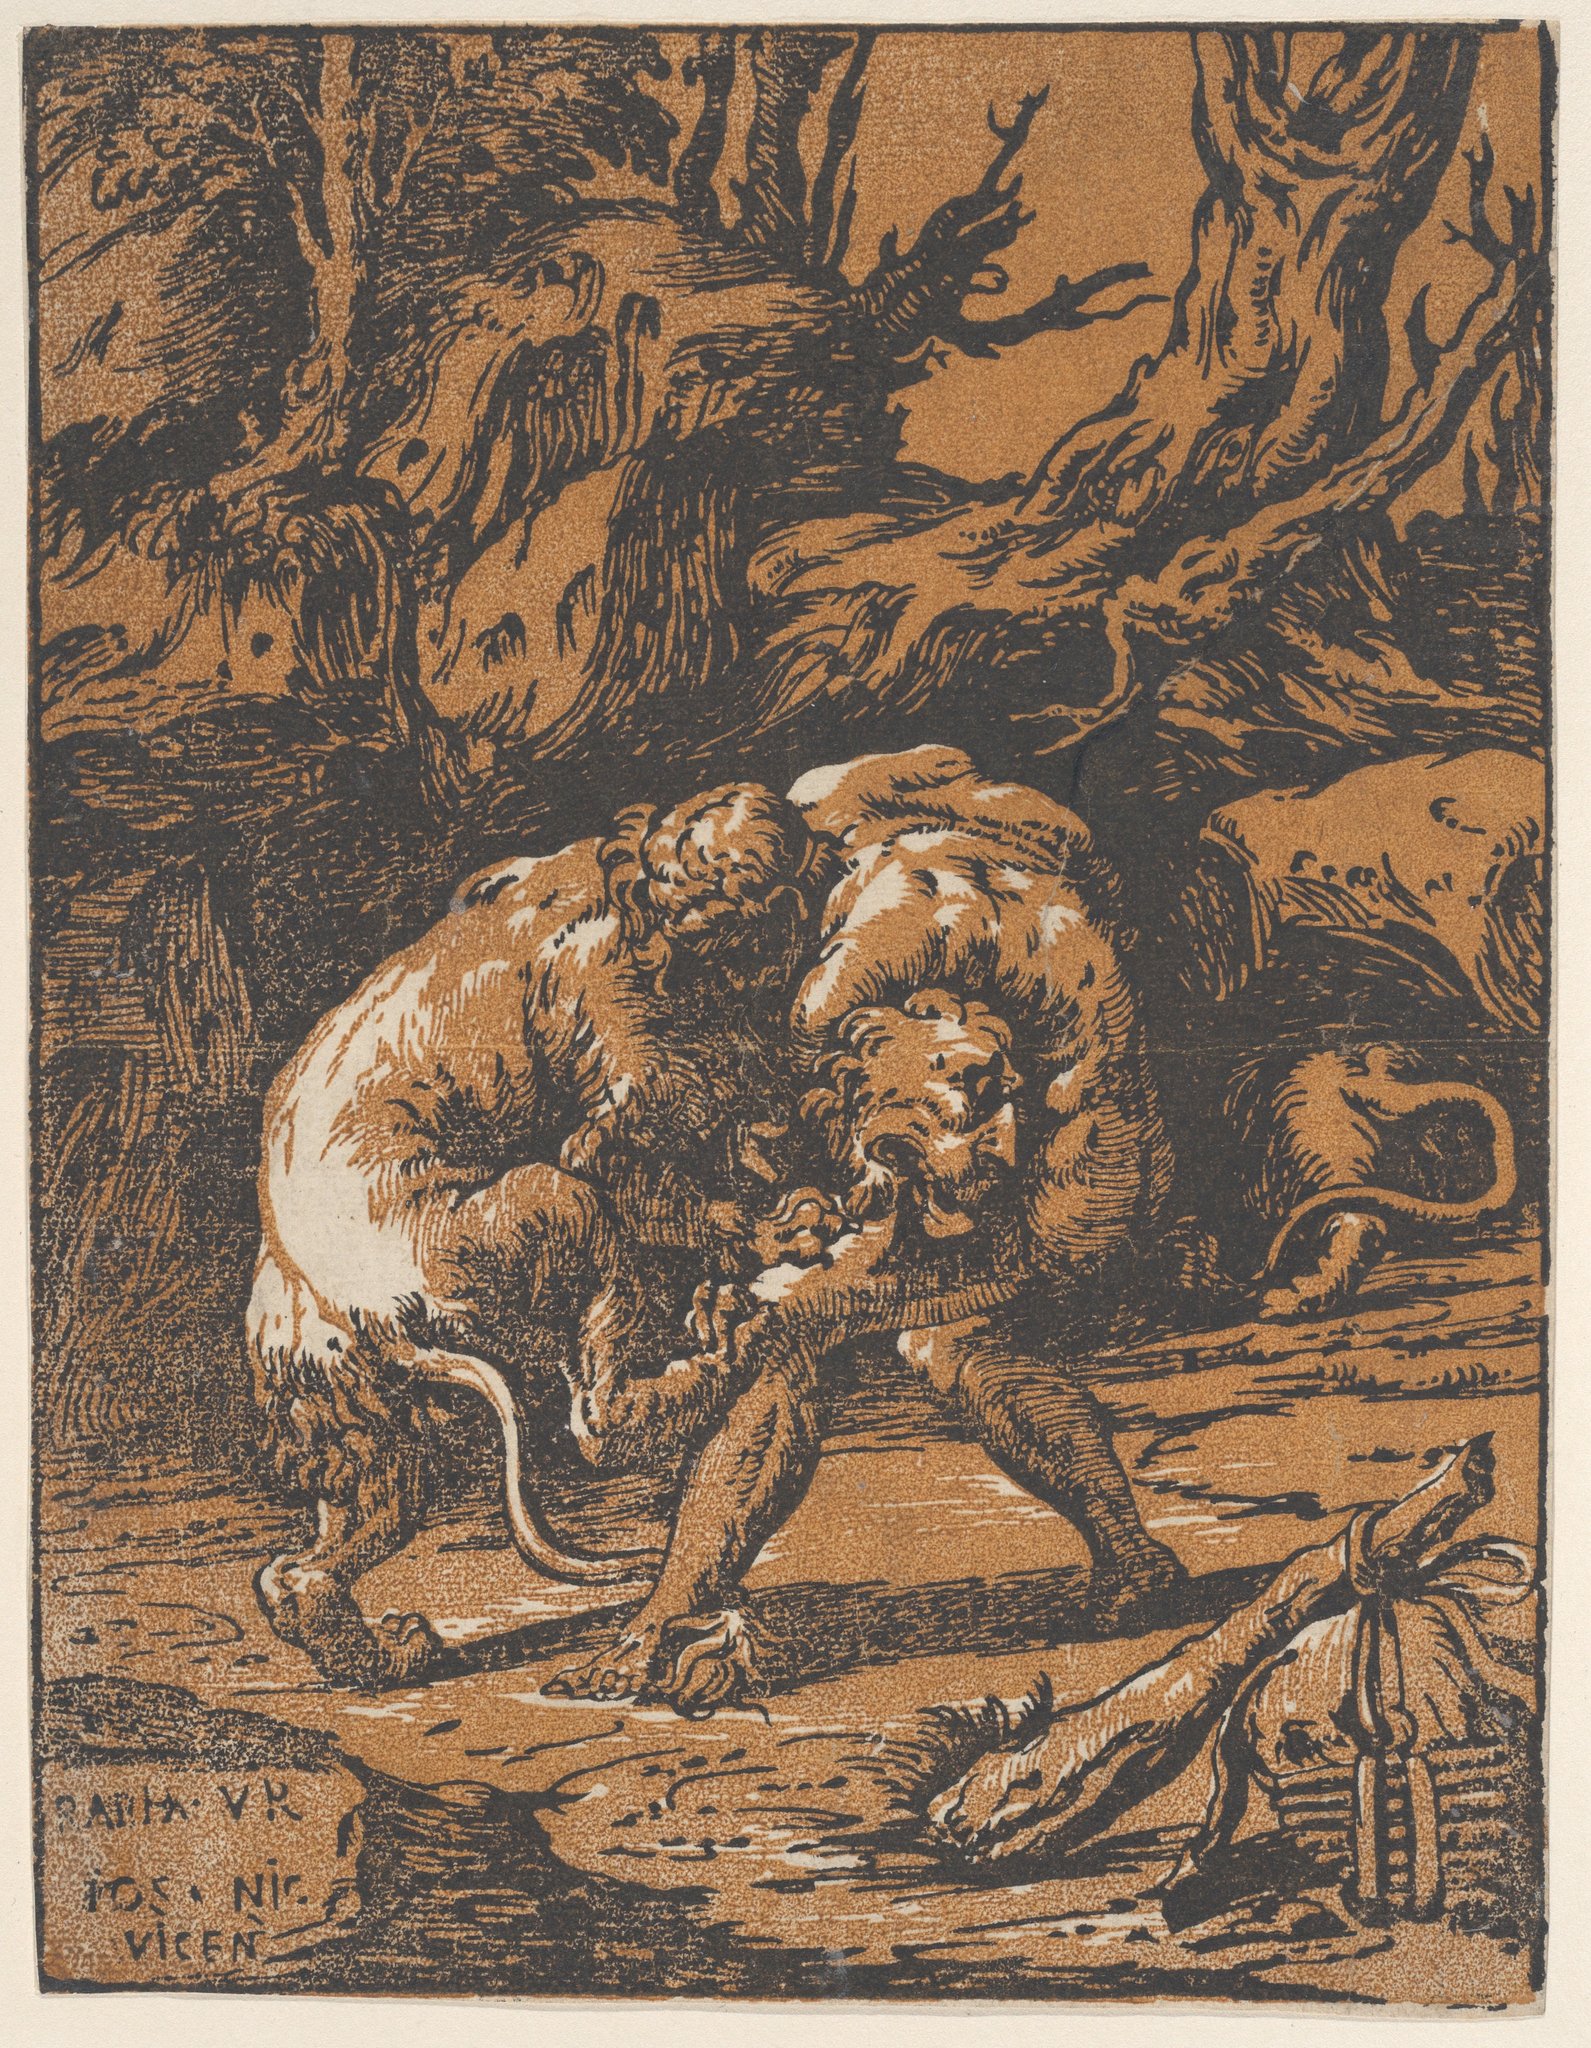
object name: print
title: Hercules and the Nemean Lion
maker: niccolò vicentino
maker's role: artist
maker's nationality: italian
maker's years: 1510-1550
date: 1540-1550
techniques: woodcut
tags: hercules,lions